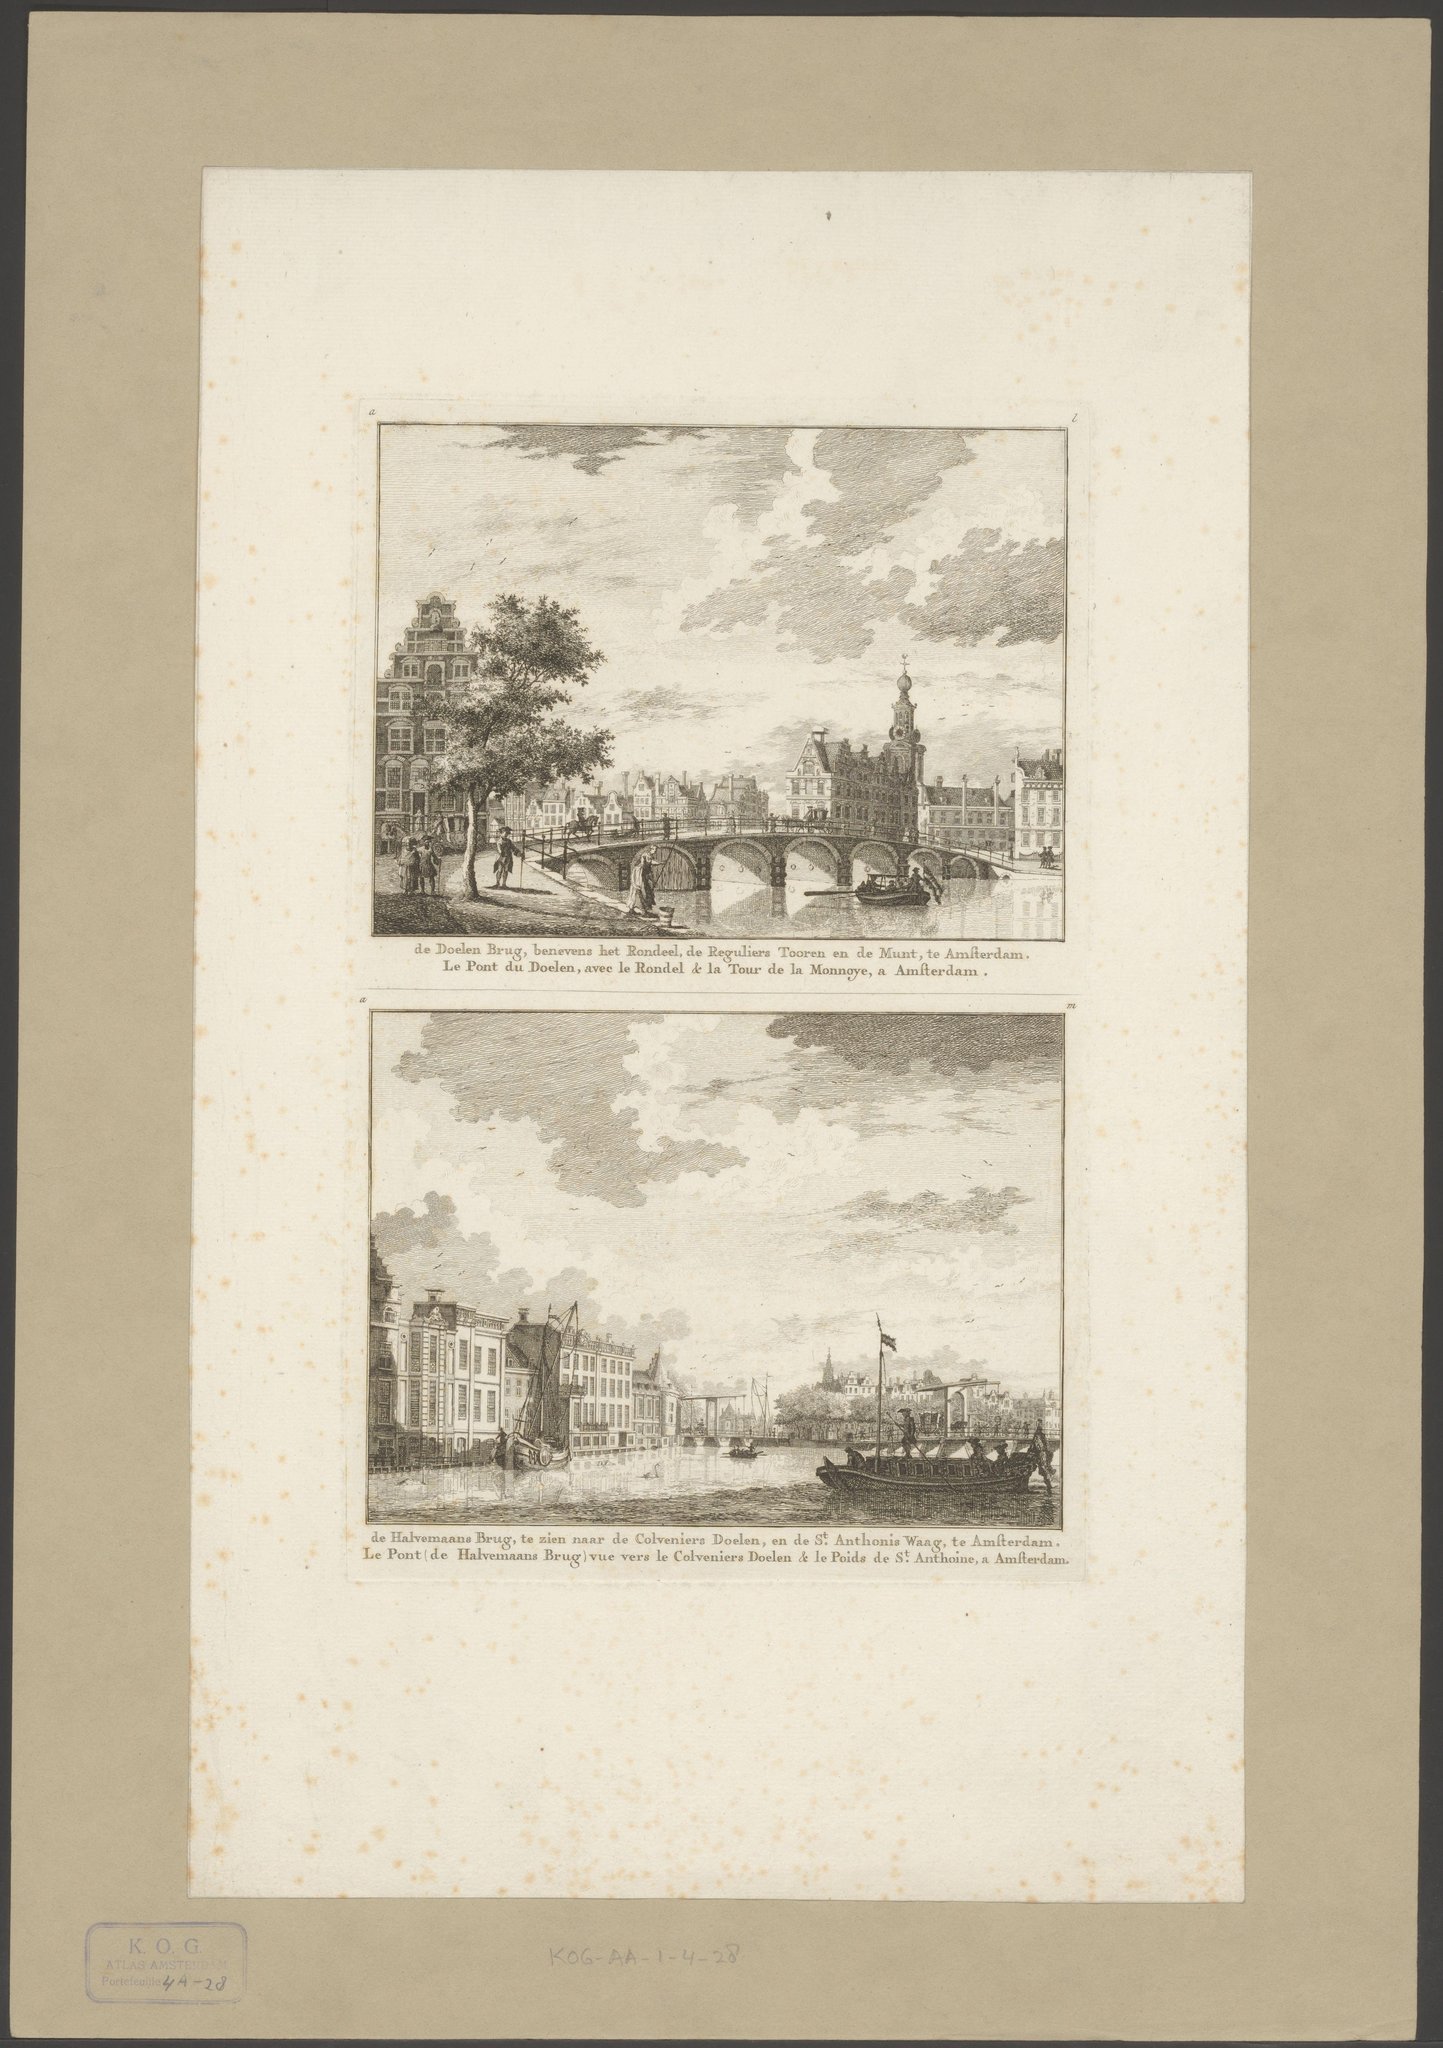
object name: print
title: De Doelen brug, benevens het Rondeel, de Reguliers Tooren en de Munt te Amsterdam / Le Punt du Doelen, avec le Rondel & la Tour de la Monnoye, a Amsterdam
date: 1804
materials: paper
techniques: etching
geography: amsterdam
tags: tower, clock tower ~ monumental adornment, city-view in general; 'veduta', canal, bridge in city across river, canal, etc., boat propelled by man or animal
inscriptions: collector's mark: ‘4A-28’ Lugt 1641b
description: Onderwerpsrubriek binnen de Atlas Amsterdam: Amstel van Doelensluis tot Blauwbrug. Bovenste prent genummerd linksboven: a. Rechtsboven: l. Onderste prent genummerd linksboven: a. Rechtsboven: m.